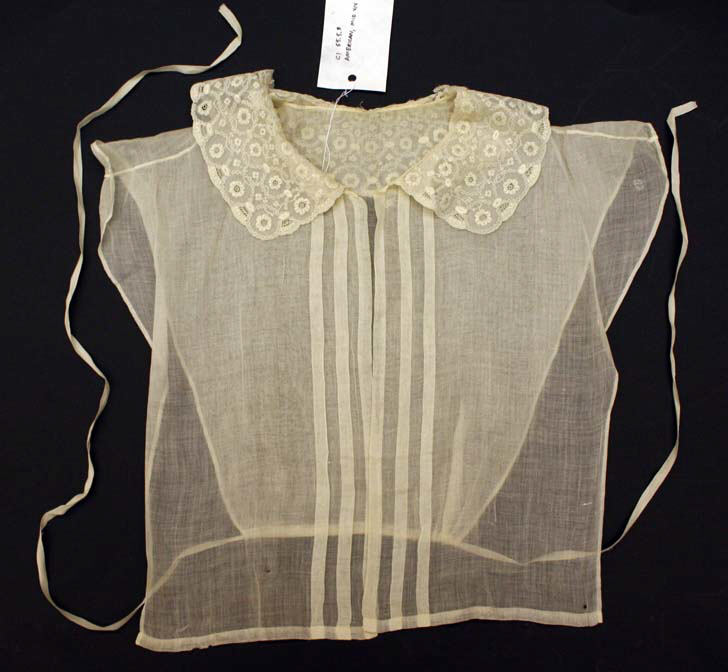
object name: chemise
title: Chemisette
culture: american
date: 1834-1866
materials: cotton